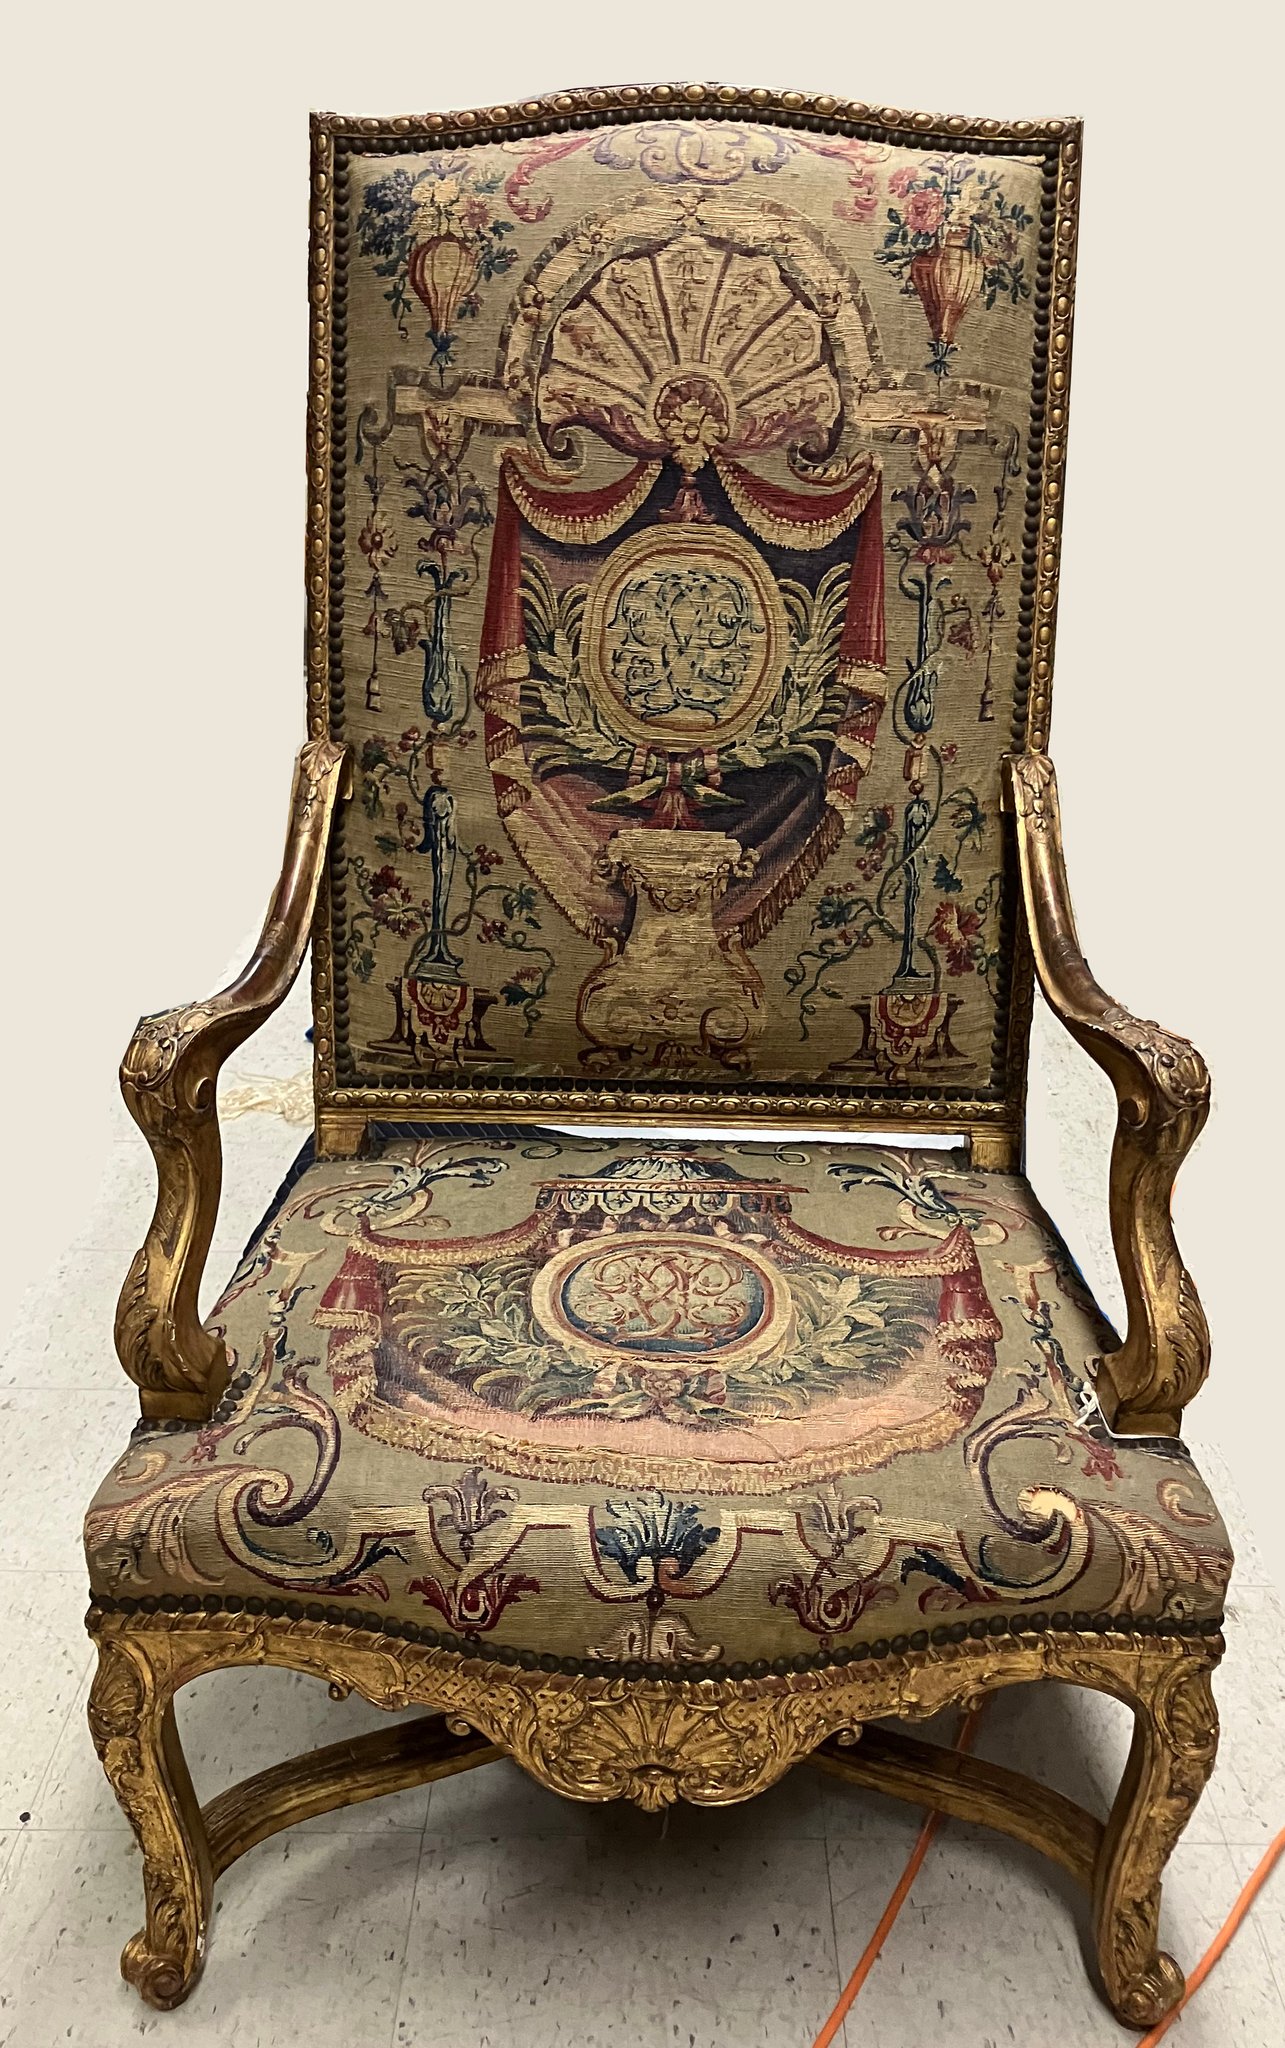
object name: armchair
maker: beauvais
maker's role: factory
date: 1715-1720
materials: wood, silk, wool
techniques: carving, gilding, tapestry